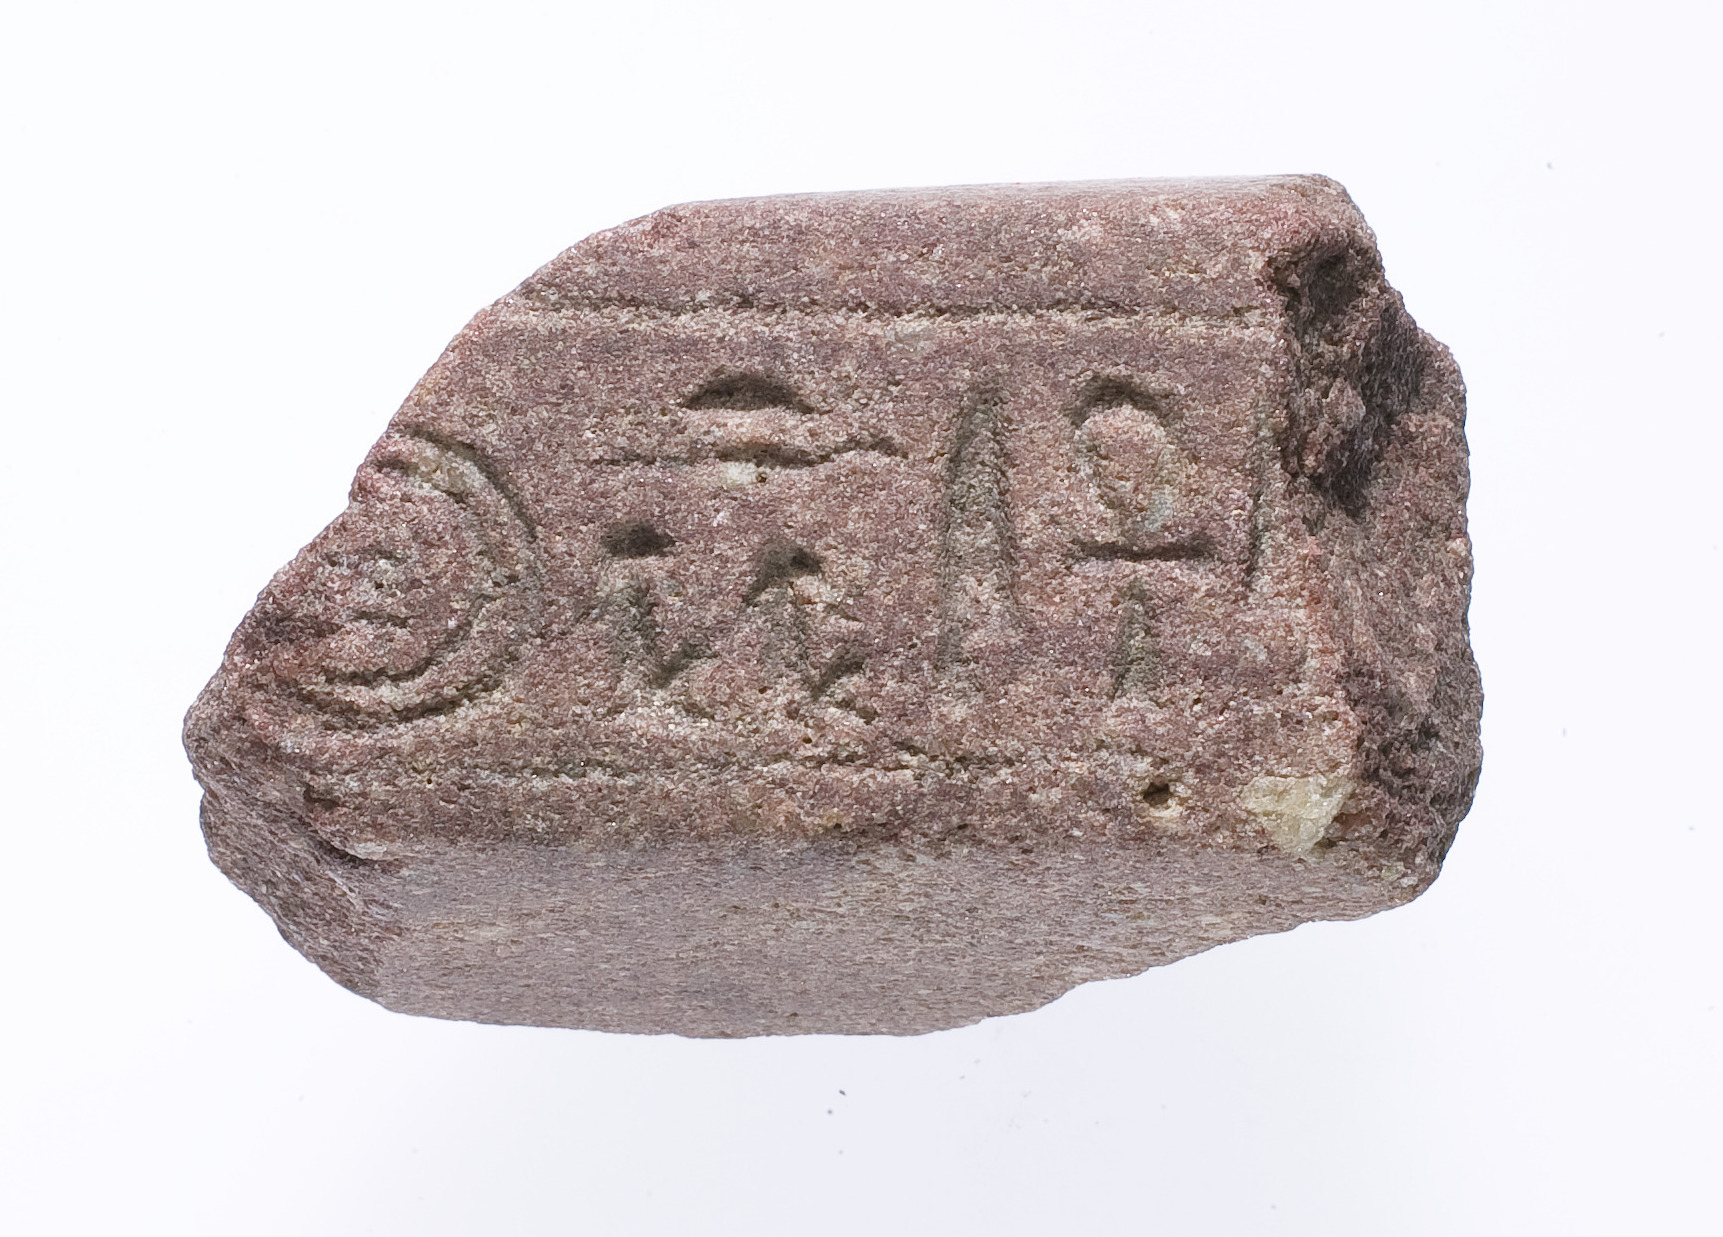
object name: offering table, aten cartouche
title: Offering table fragment with cartouche and epithets of Aten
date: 1353-1336 BCE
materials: quartzite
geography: egypt